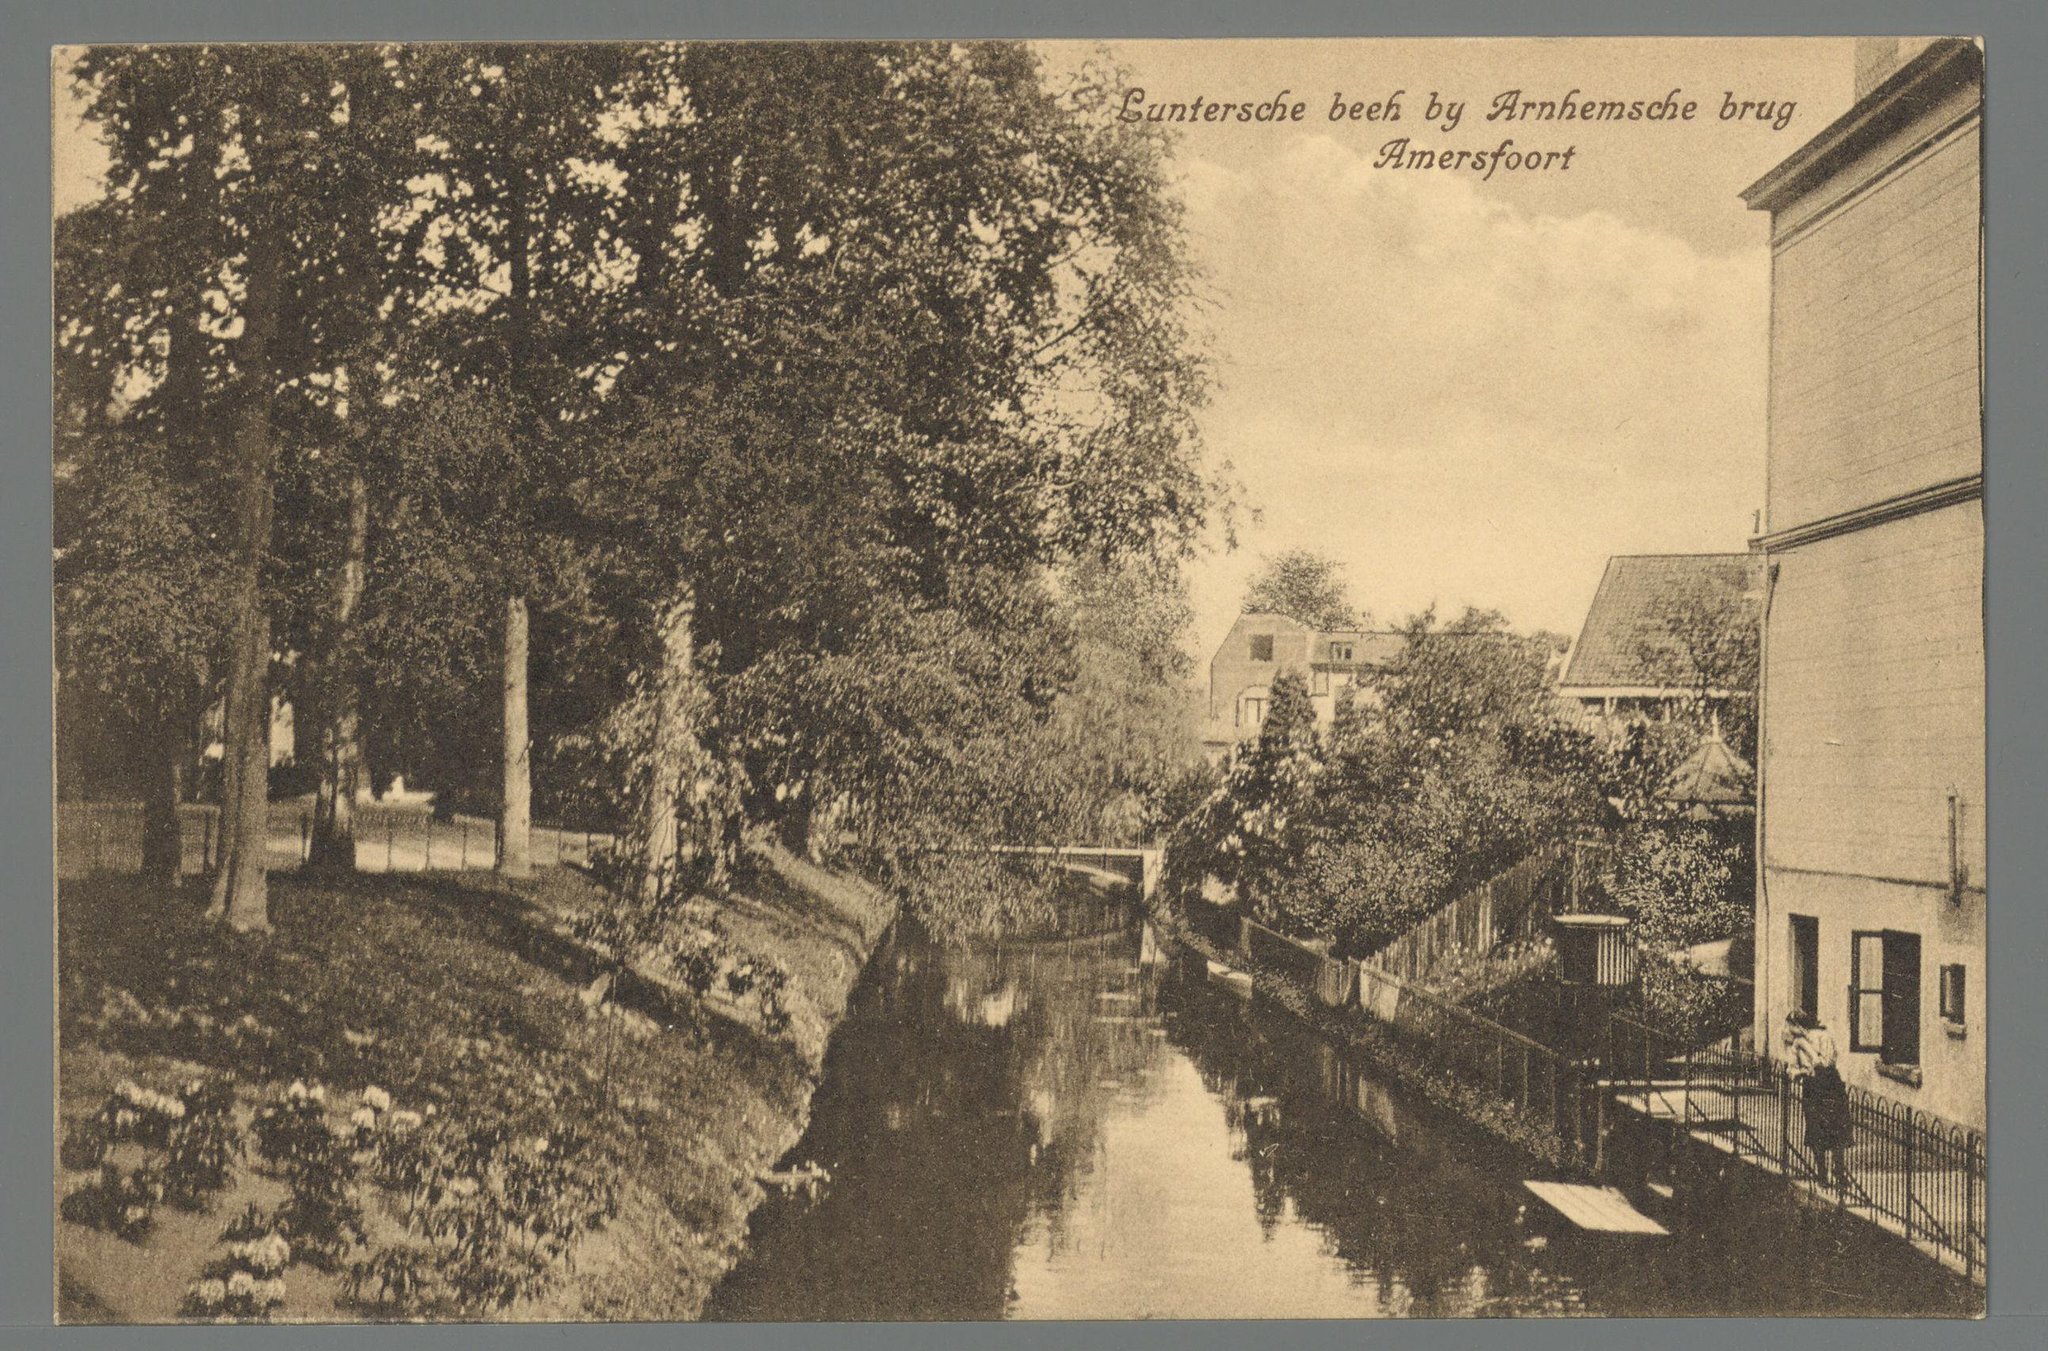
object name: photomechanical print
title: Luntersche beek by Arnhemsche brug. Amersfoort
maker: Anonymous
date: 1905-1930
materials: cardboard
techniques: photograph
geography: amersfoort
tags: canals, waters (in city), bridge in city across river, canal, etc.